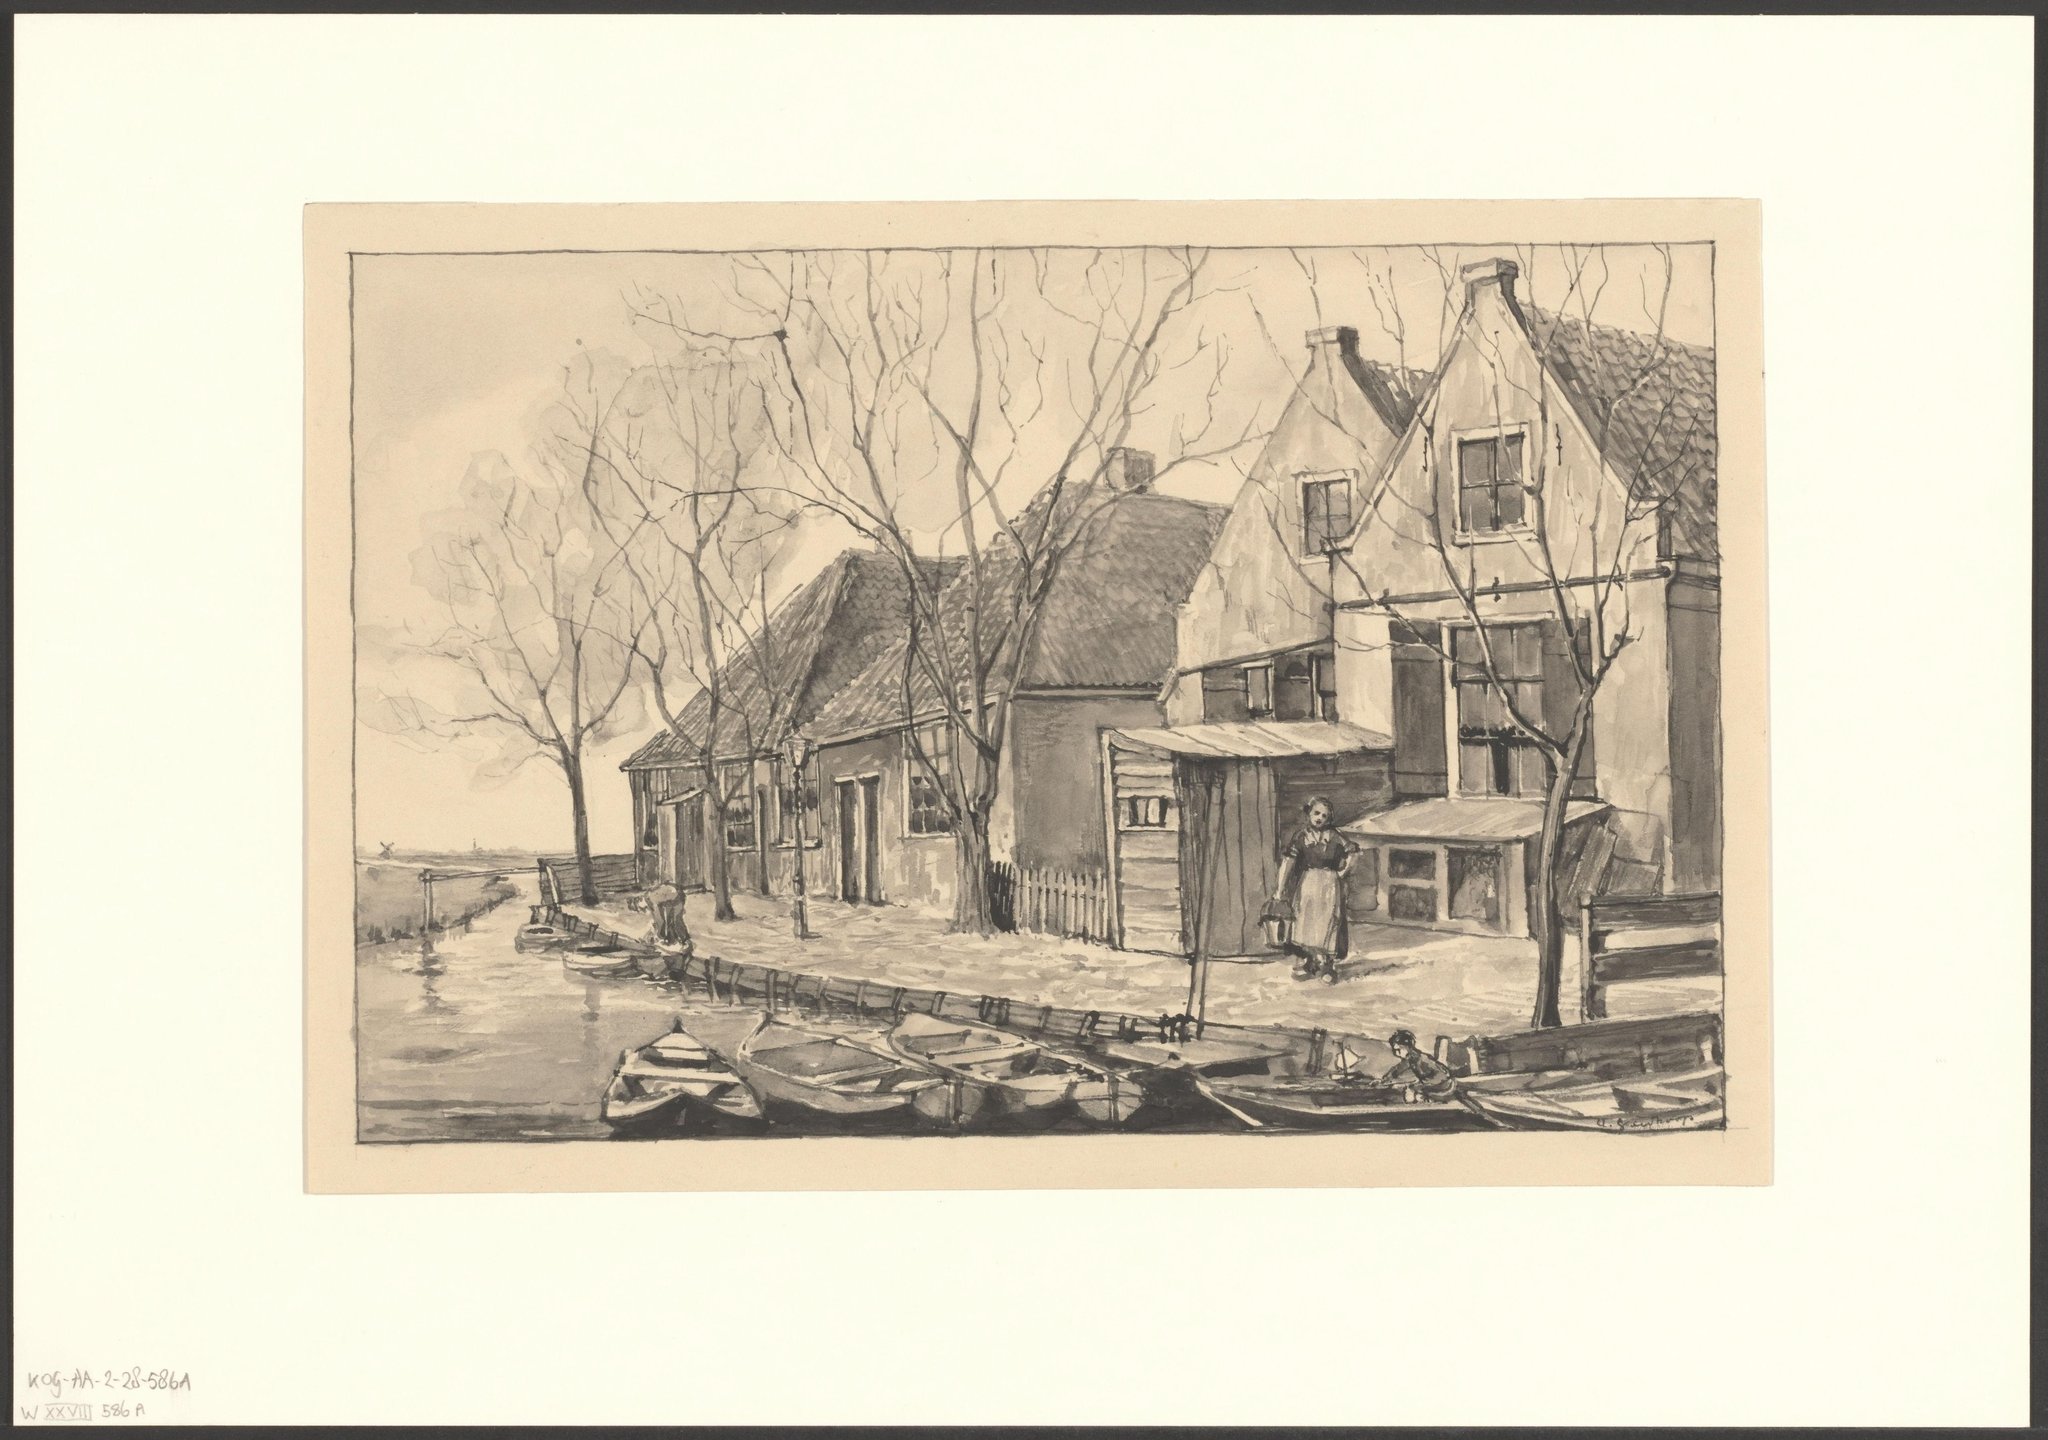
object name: drawing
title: Gezicht op 't Eilandje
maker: goedkoop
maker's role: draughtsman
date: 1850-1922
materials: ink, paper, pencil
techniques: brush, pen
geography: amsterdam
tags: city-view in general; 'veduta', small canal, ditch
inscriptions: inscription: ‘A/d overtoom Baarsjes. (...) overtoomsche vaart / overtoom’, signature: ‘a. goedkoop’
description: Tekening binnen de Atlas Van Eck ingedeeld op wijknummer 28.